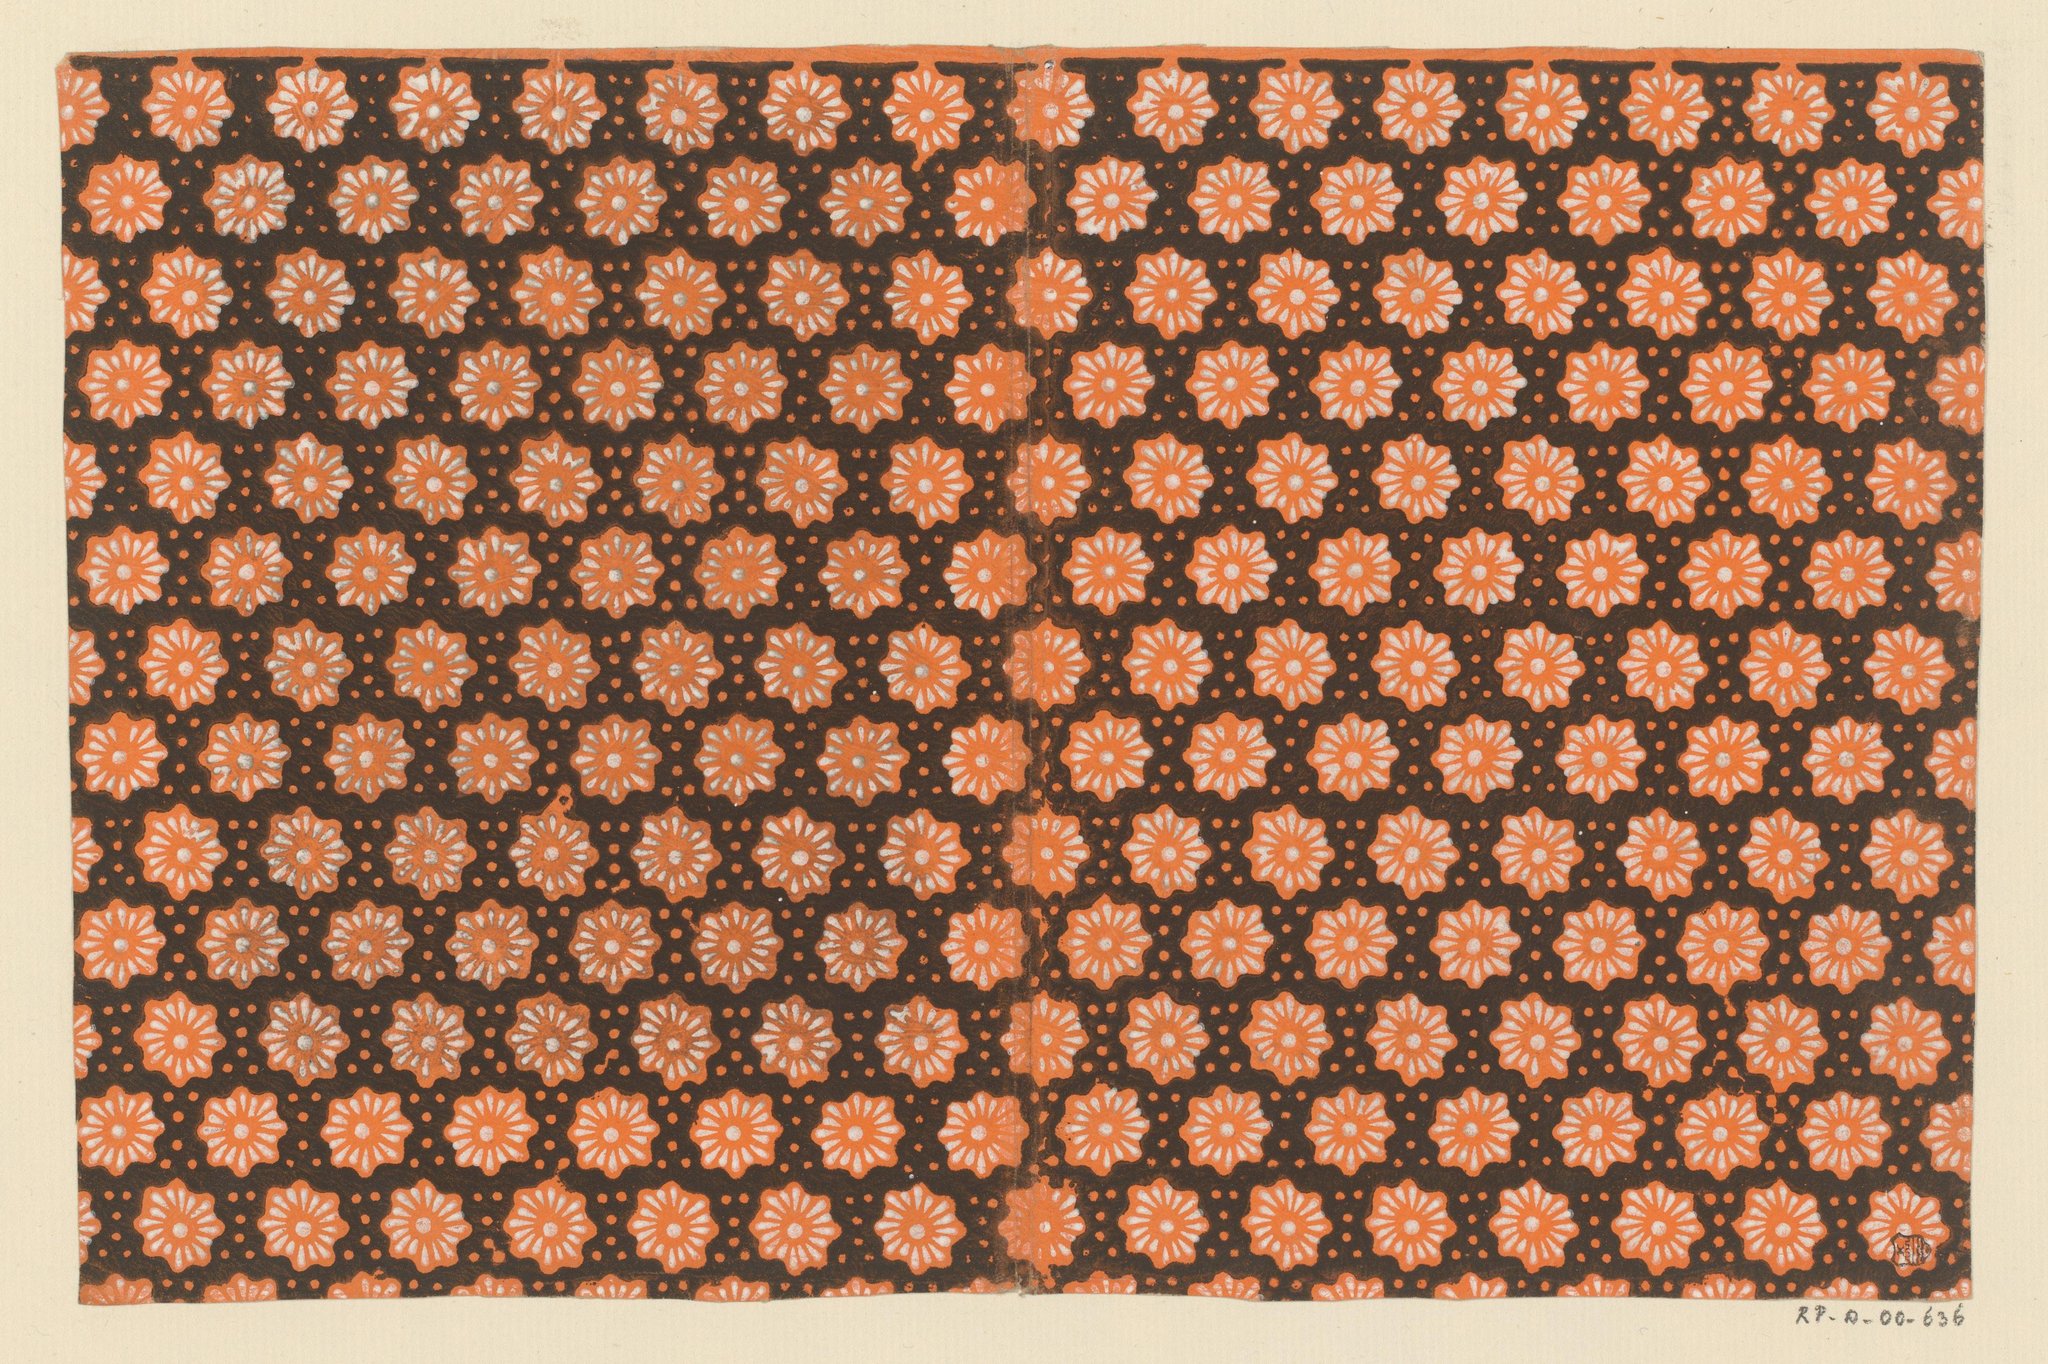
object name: wrapper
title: Blad met strooipatroon van bloemmotief omgeven door punten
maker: Anonymous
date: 1750-1900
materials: paper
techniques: printing block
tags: ornament derived from plant forms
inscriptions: collector's mark: Lugt 2760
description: Blad met strooipatroon van een bloemmotief tussen punten. Gebruikt als omslag.